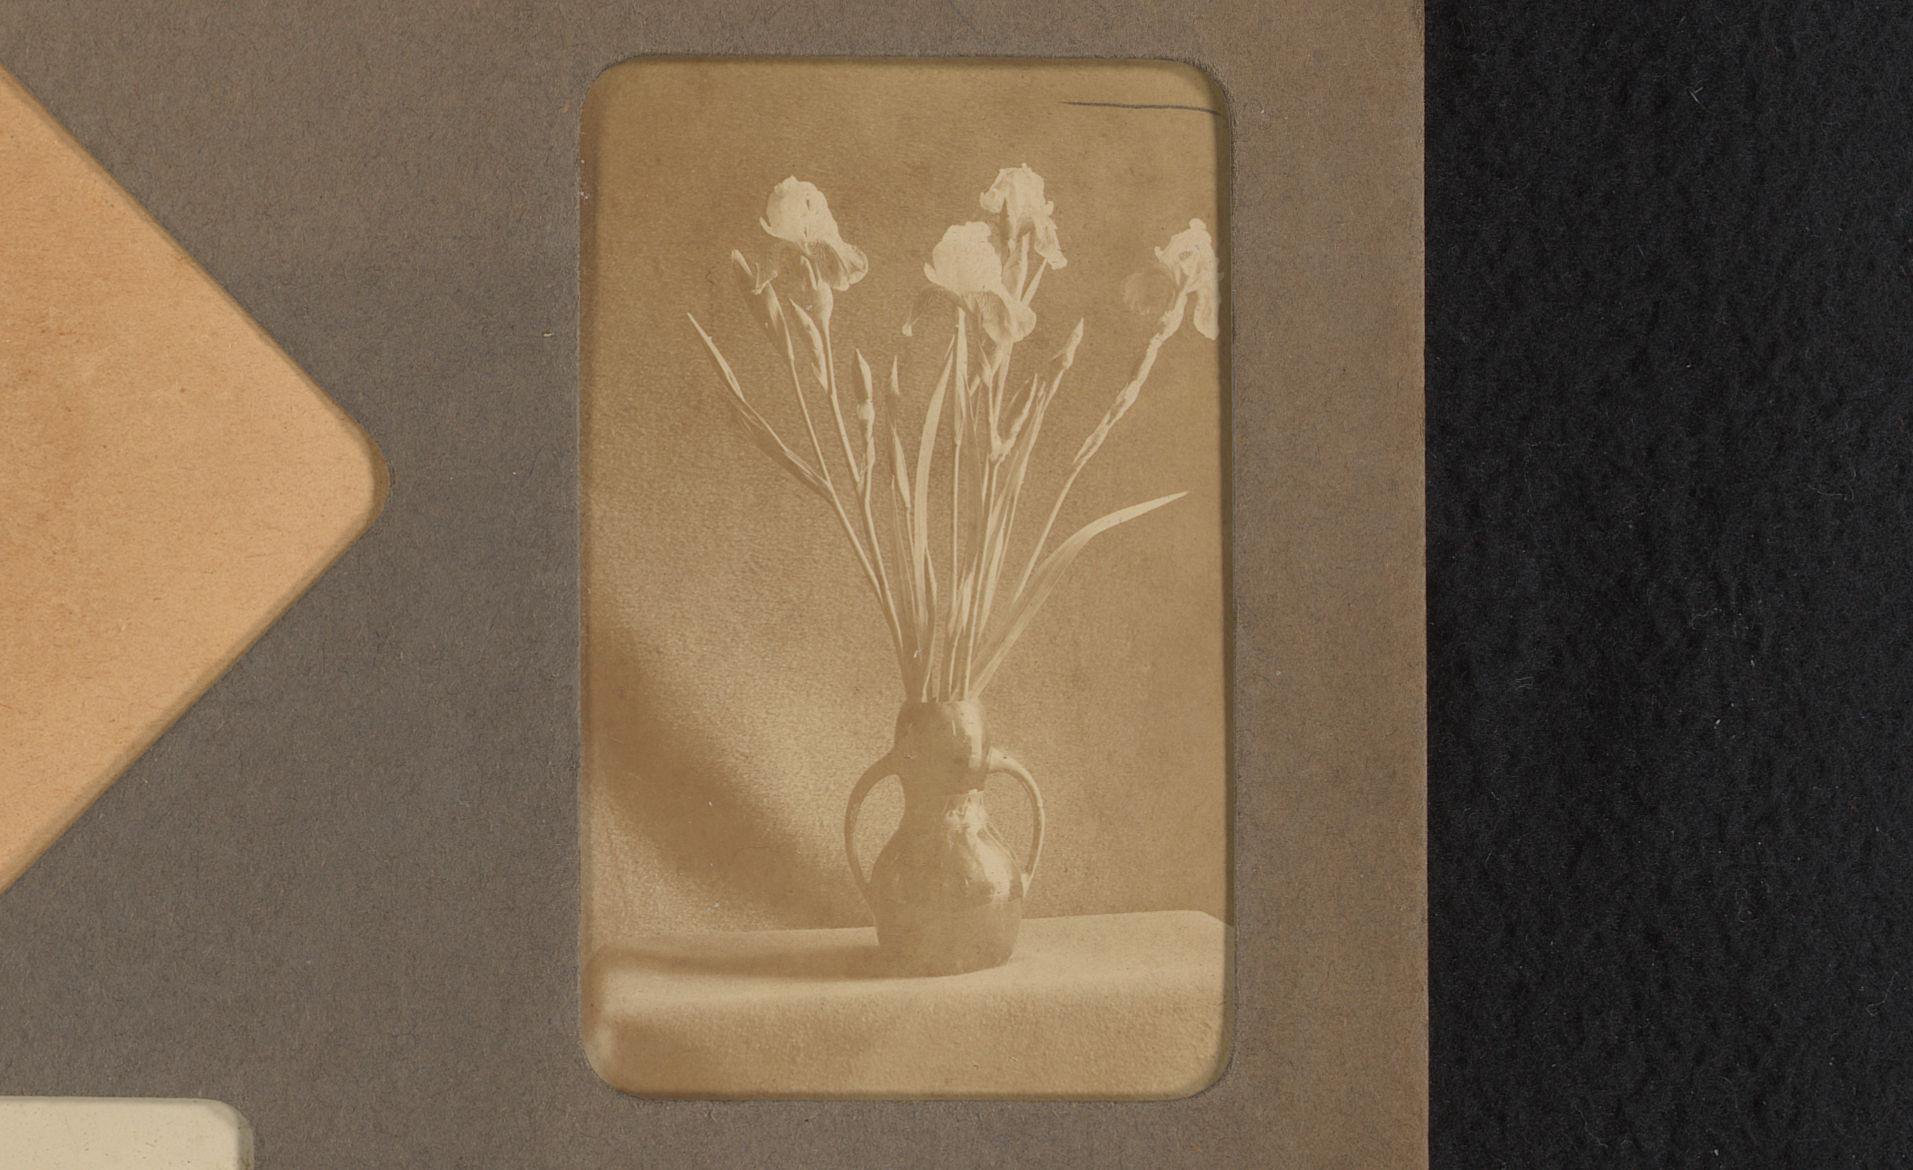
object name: photograph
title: Stilleven met een boeket lissen in een vaas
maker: Anonymous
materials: paper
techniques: gelatin silver print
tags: flowers